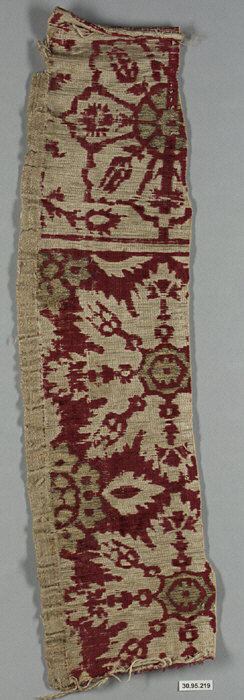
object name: textile fragment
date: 1601-1700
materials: metal thread, silk, velvet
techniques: cutting, voiding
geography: turkey